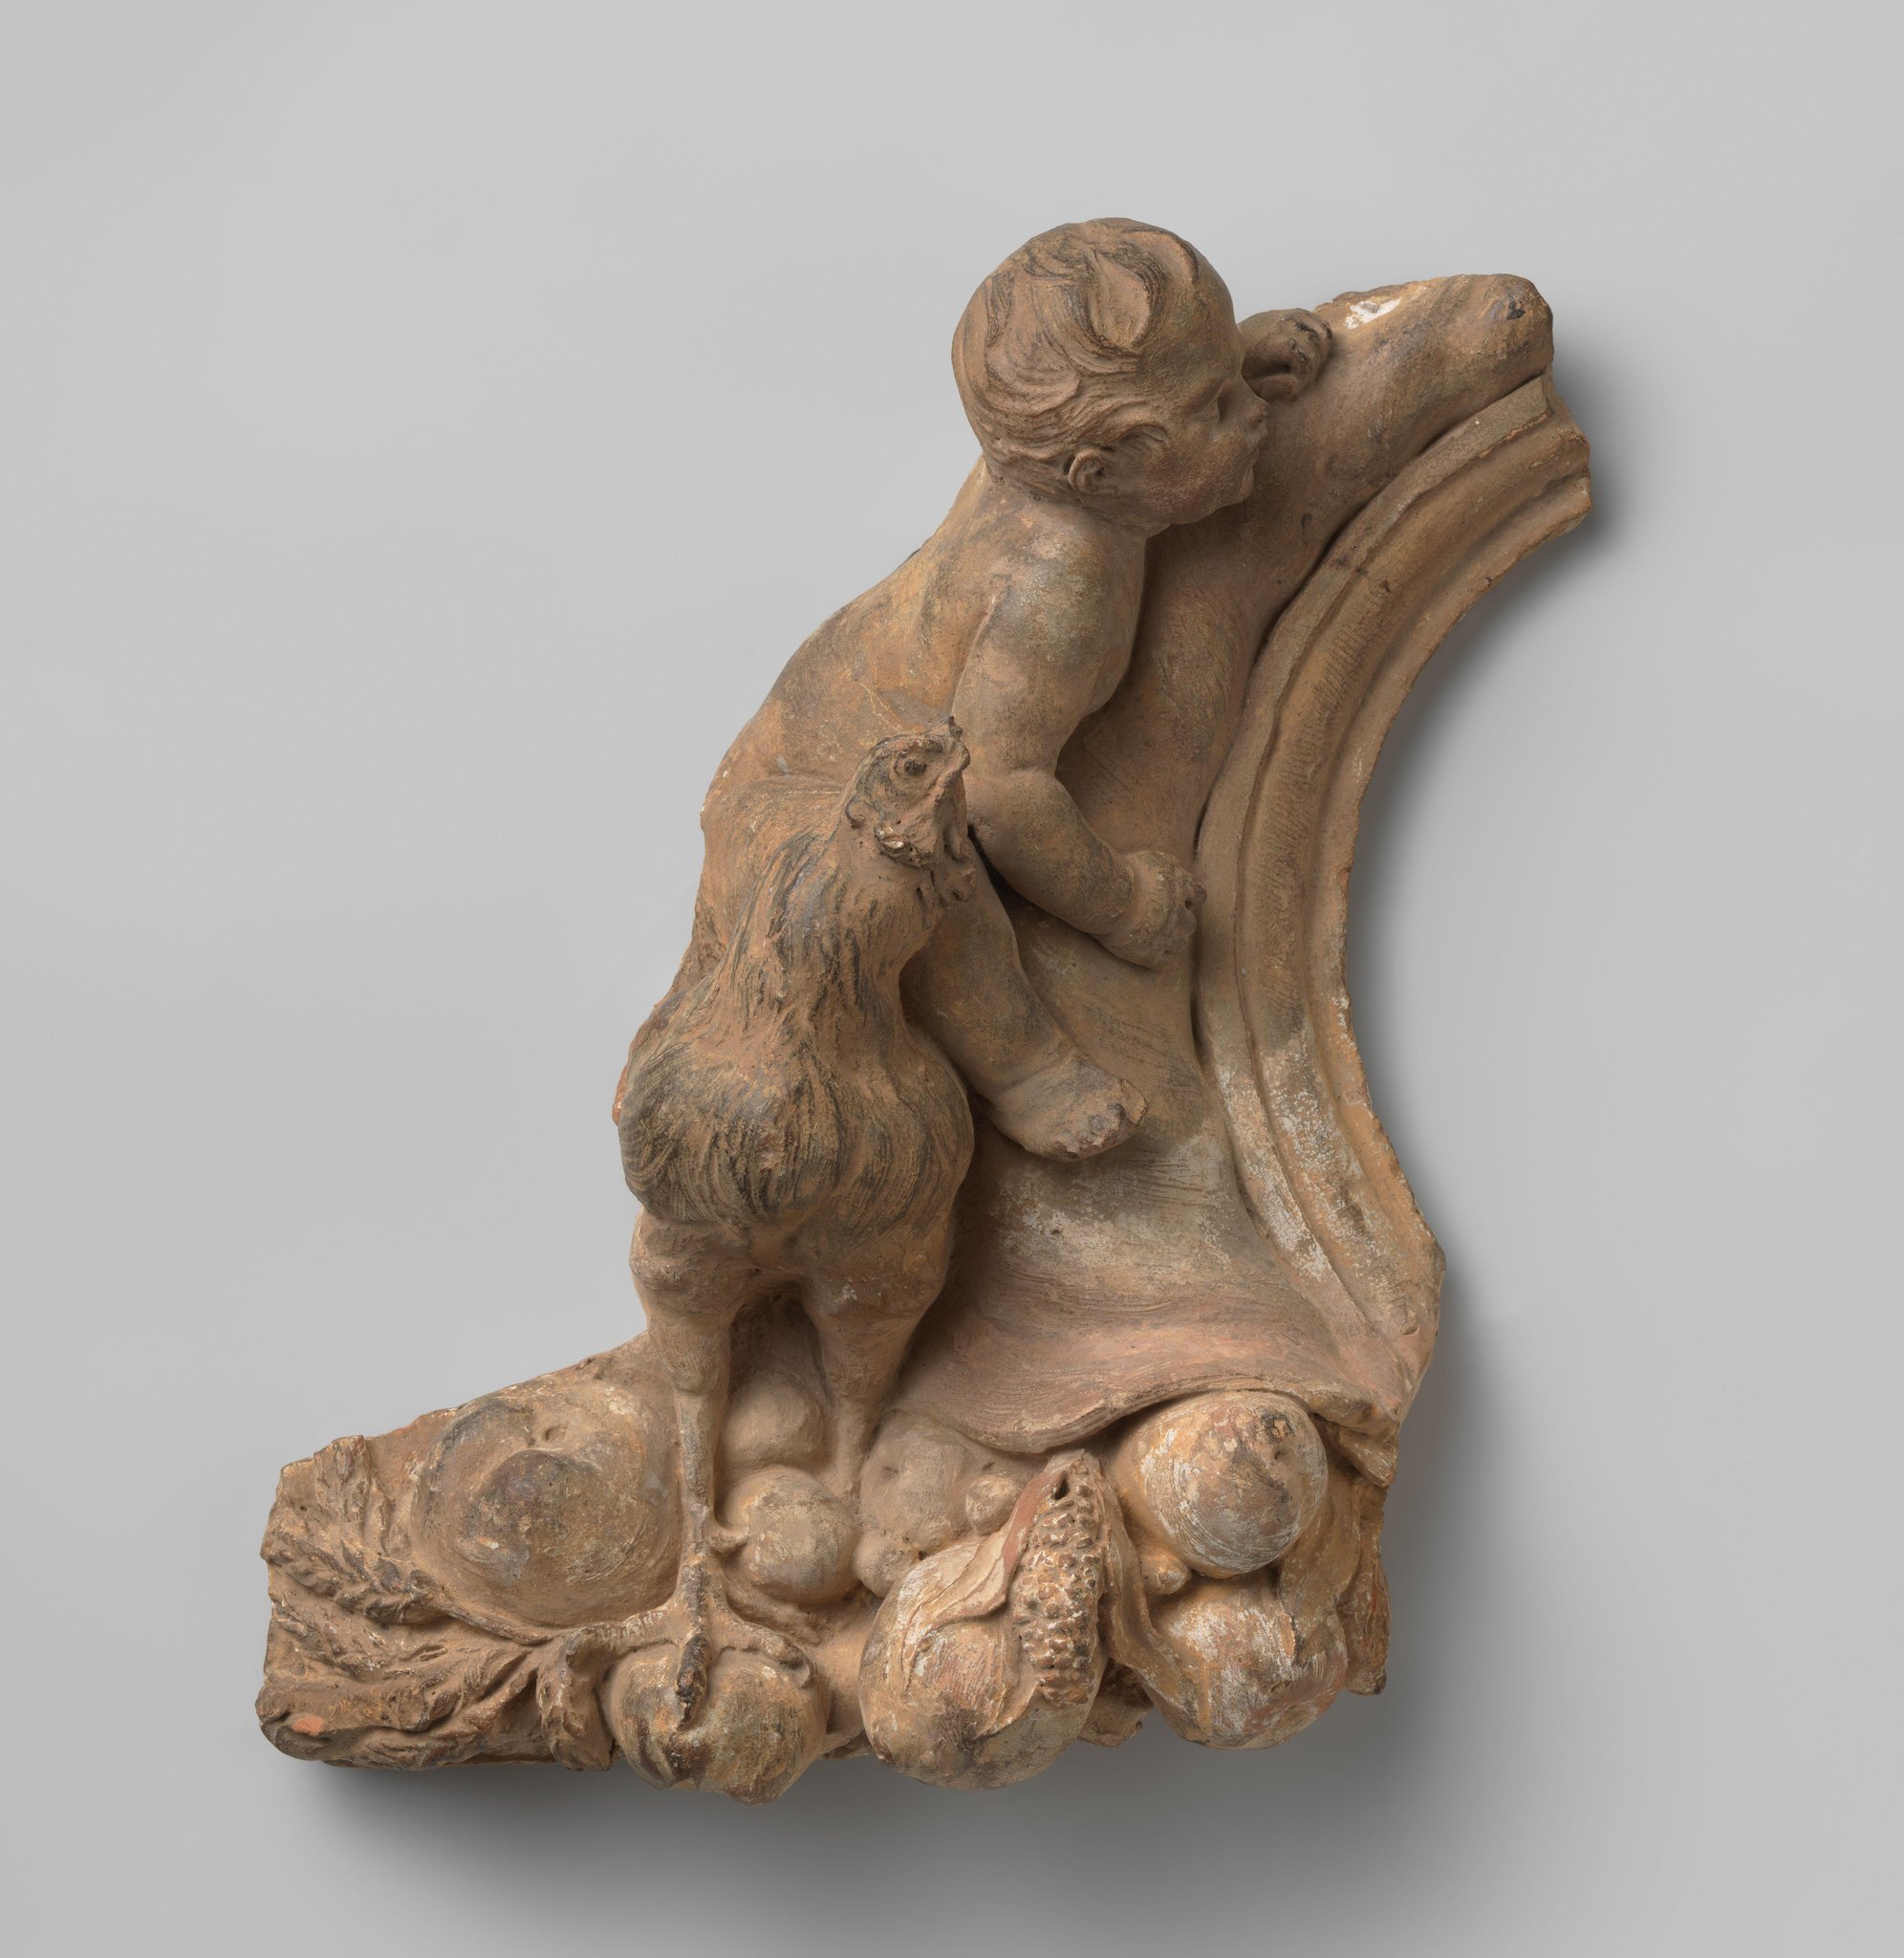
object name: model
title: Bekroning met hanen, linker helft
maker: artus quellinus (i)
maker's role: draughtsman, print maker, sculptor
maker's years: 1609-1668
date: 1650-1651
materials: terracotta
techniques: modeling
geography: amsterdam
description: Het fragment van de linker helft geeft een deel van de omlijsting met een hoorn, waaruit vruchten vallen; tegen de hoorn klautert een kind naast wie een kraaiende haan staat.